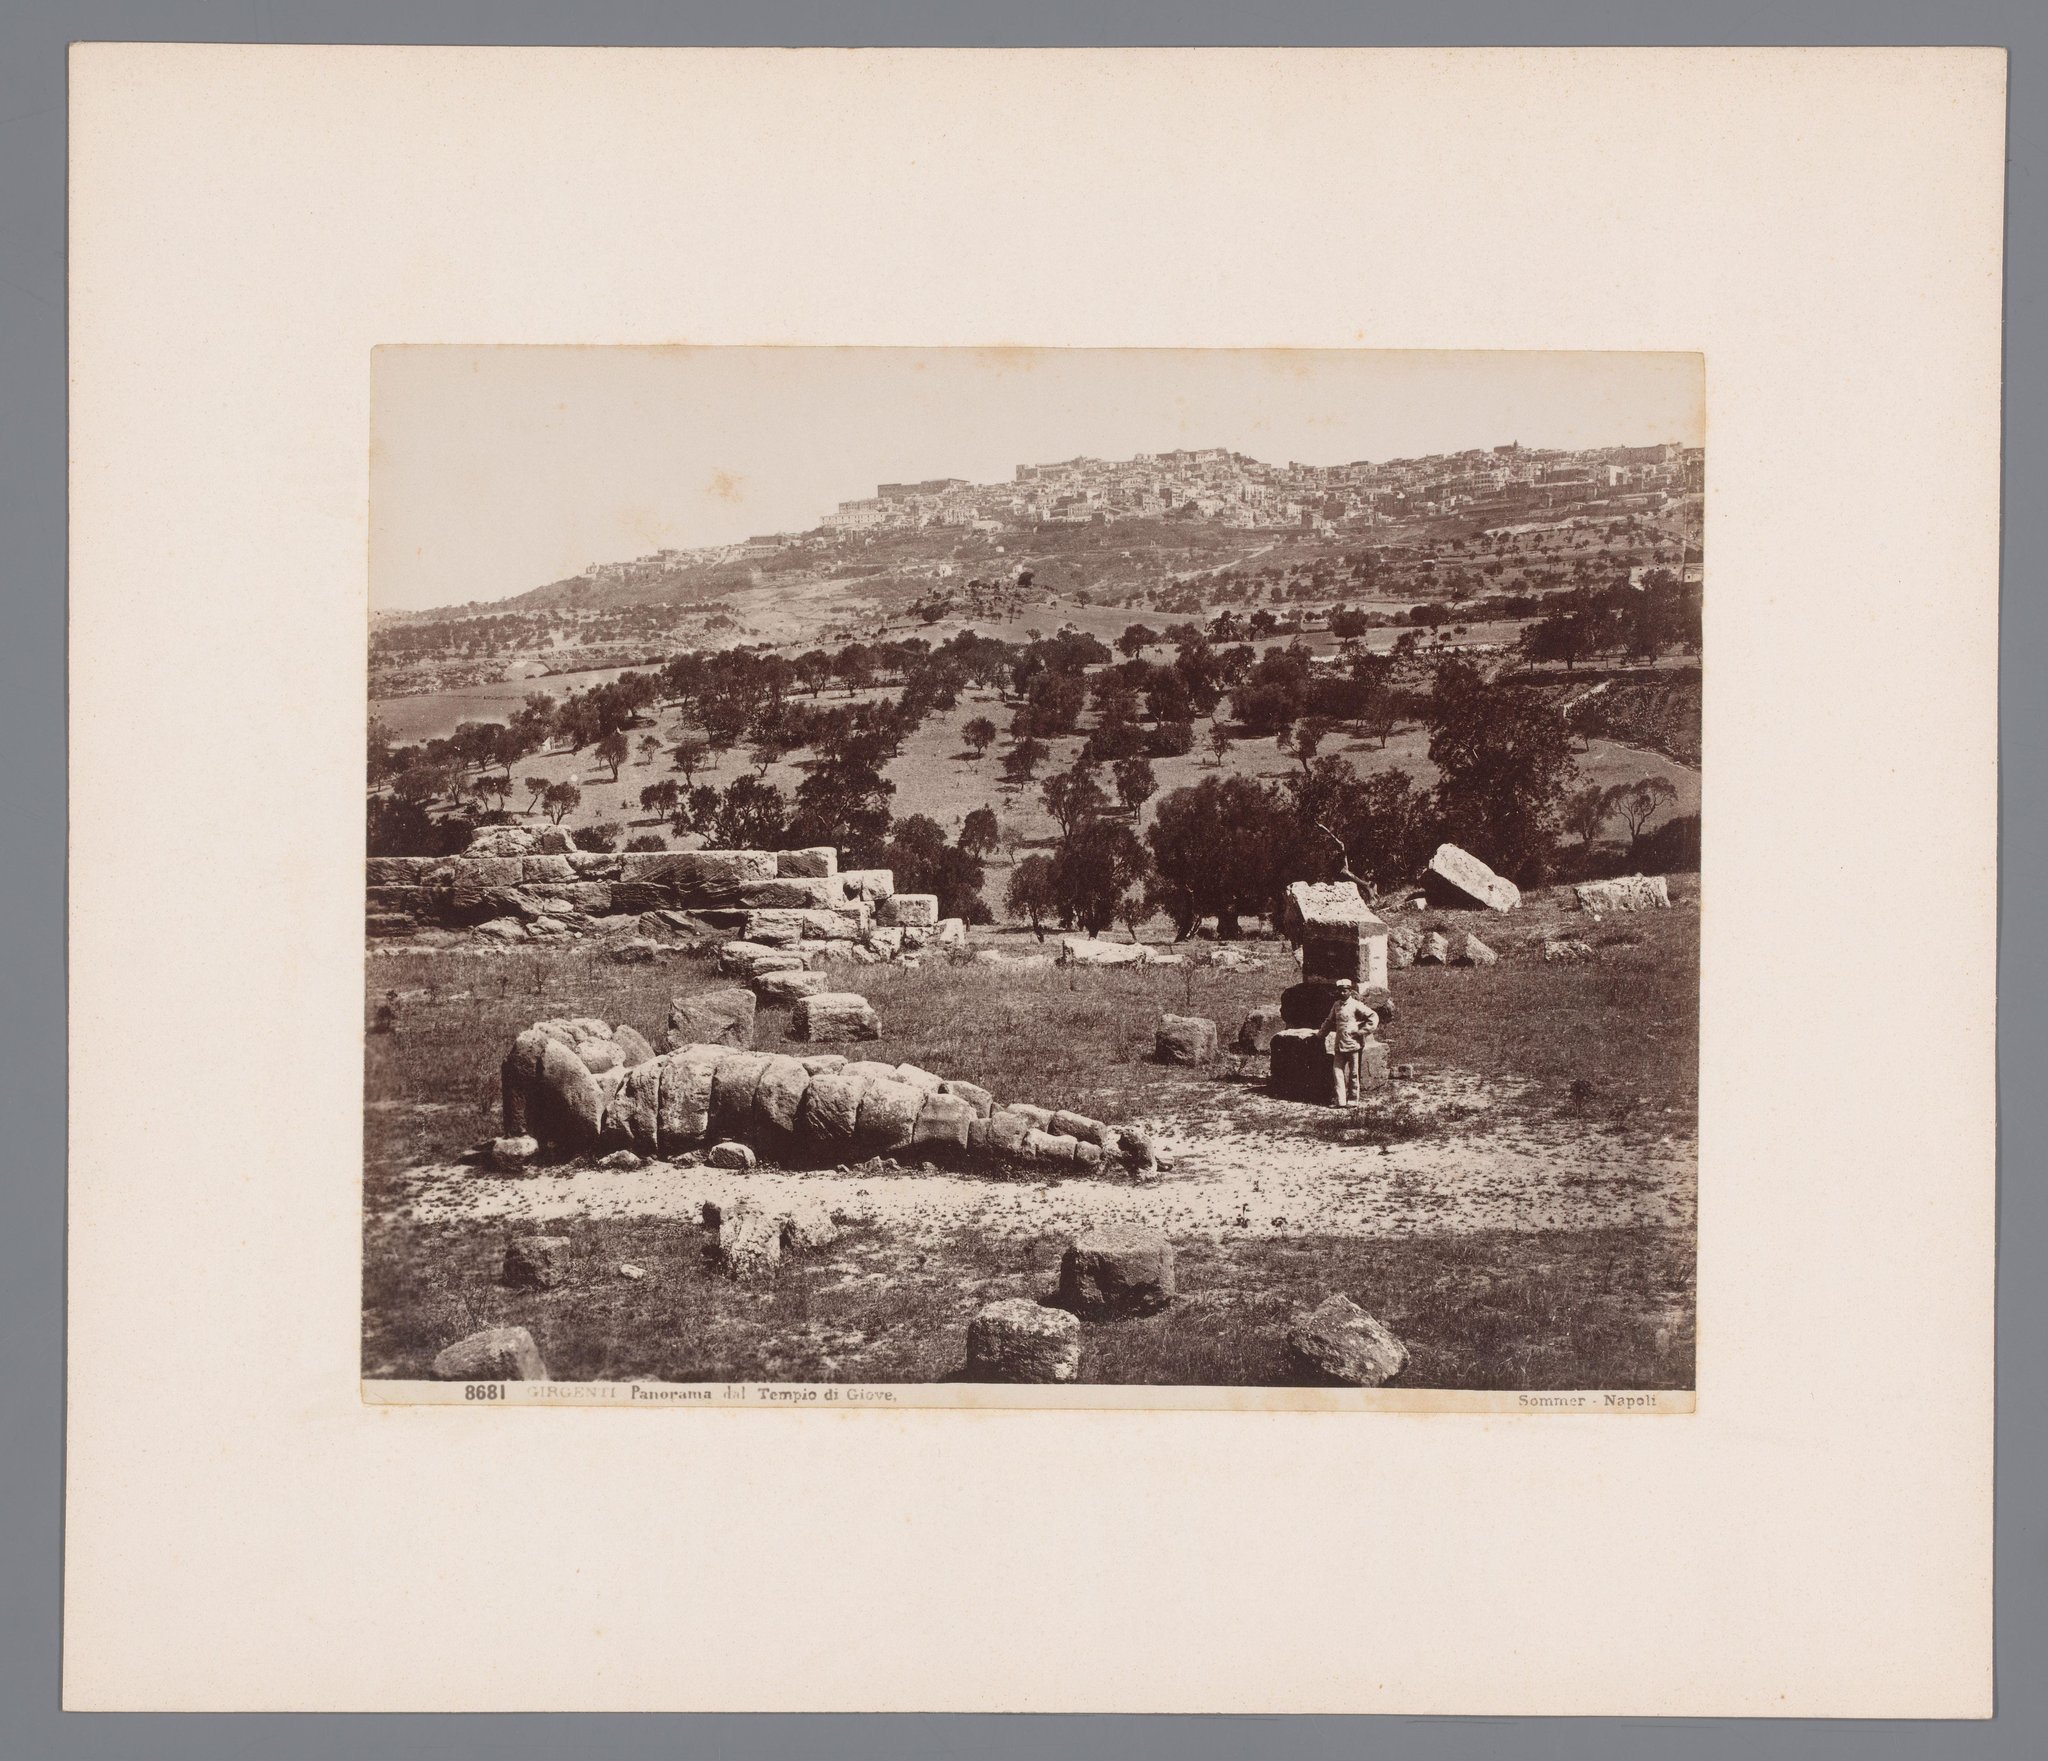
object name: photograph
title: Girgenti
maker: giorgio sommer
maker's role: fotograaf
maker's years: 1834-1914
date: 1857-1914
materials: cardboard, paper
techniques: albumen print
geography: agrigento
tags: dale, valley, city-view in general; 'veduta'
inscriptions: number: ‘8681’